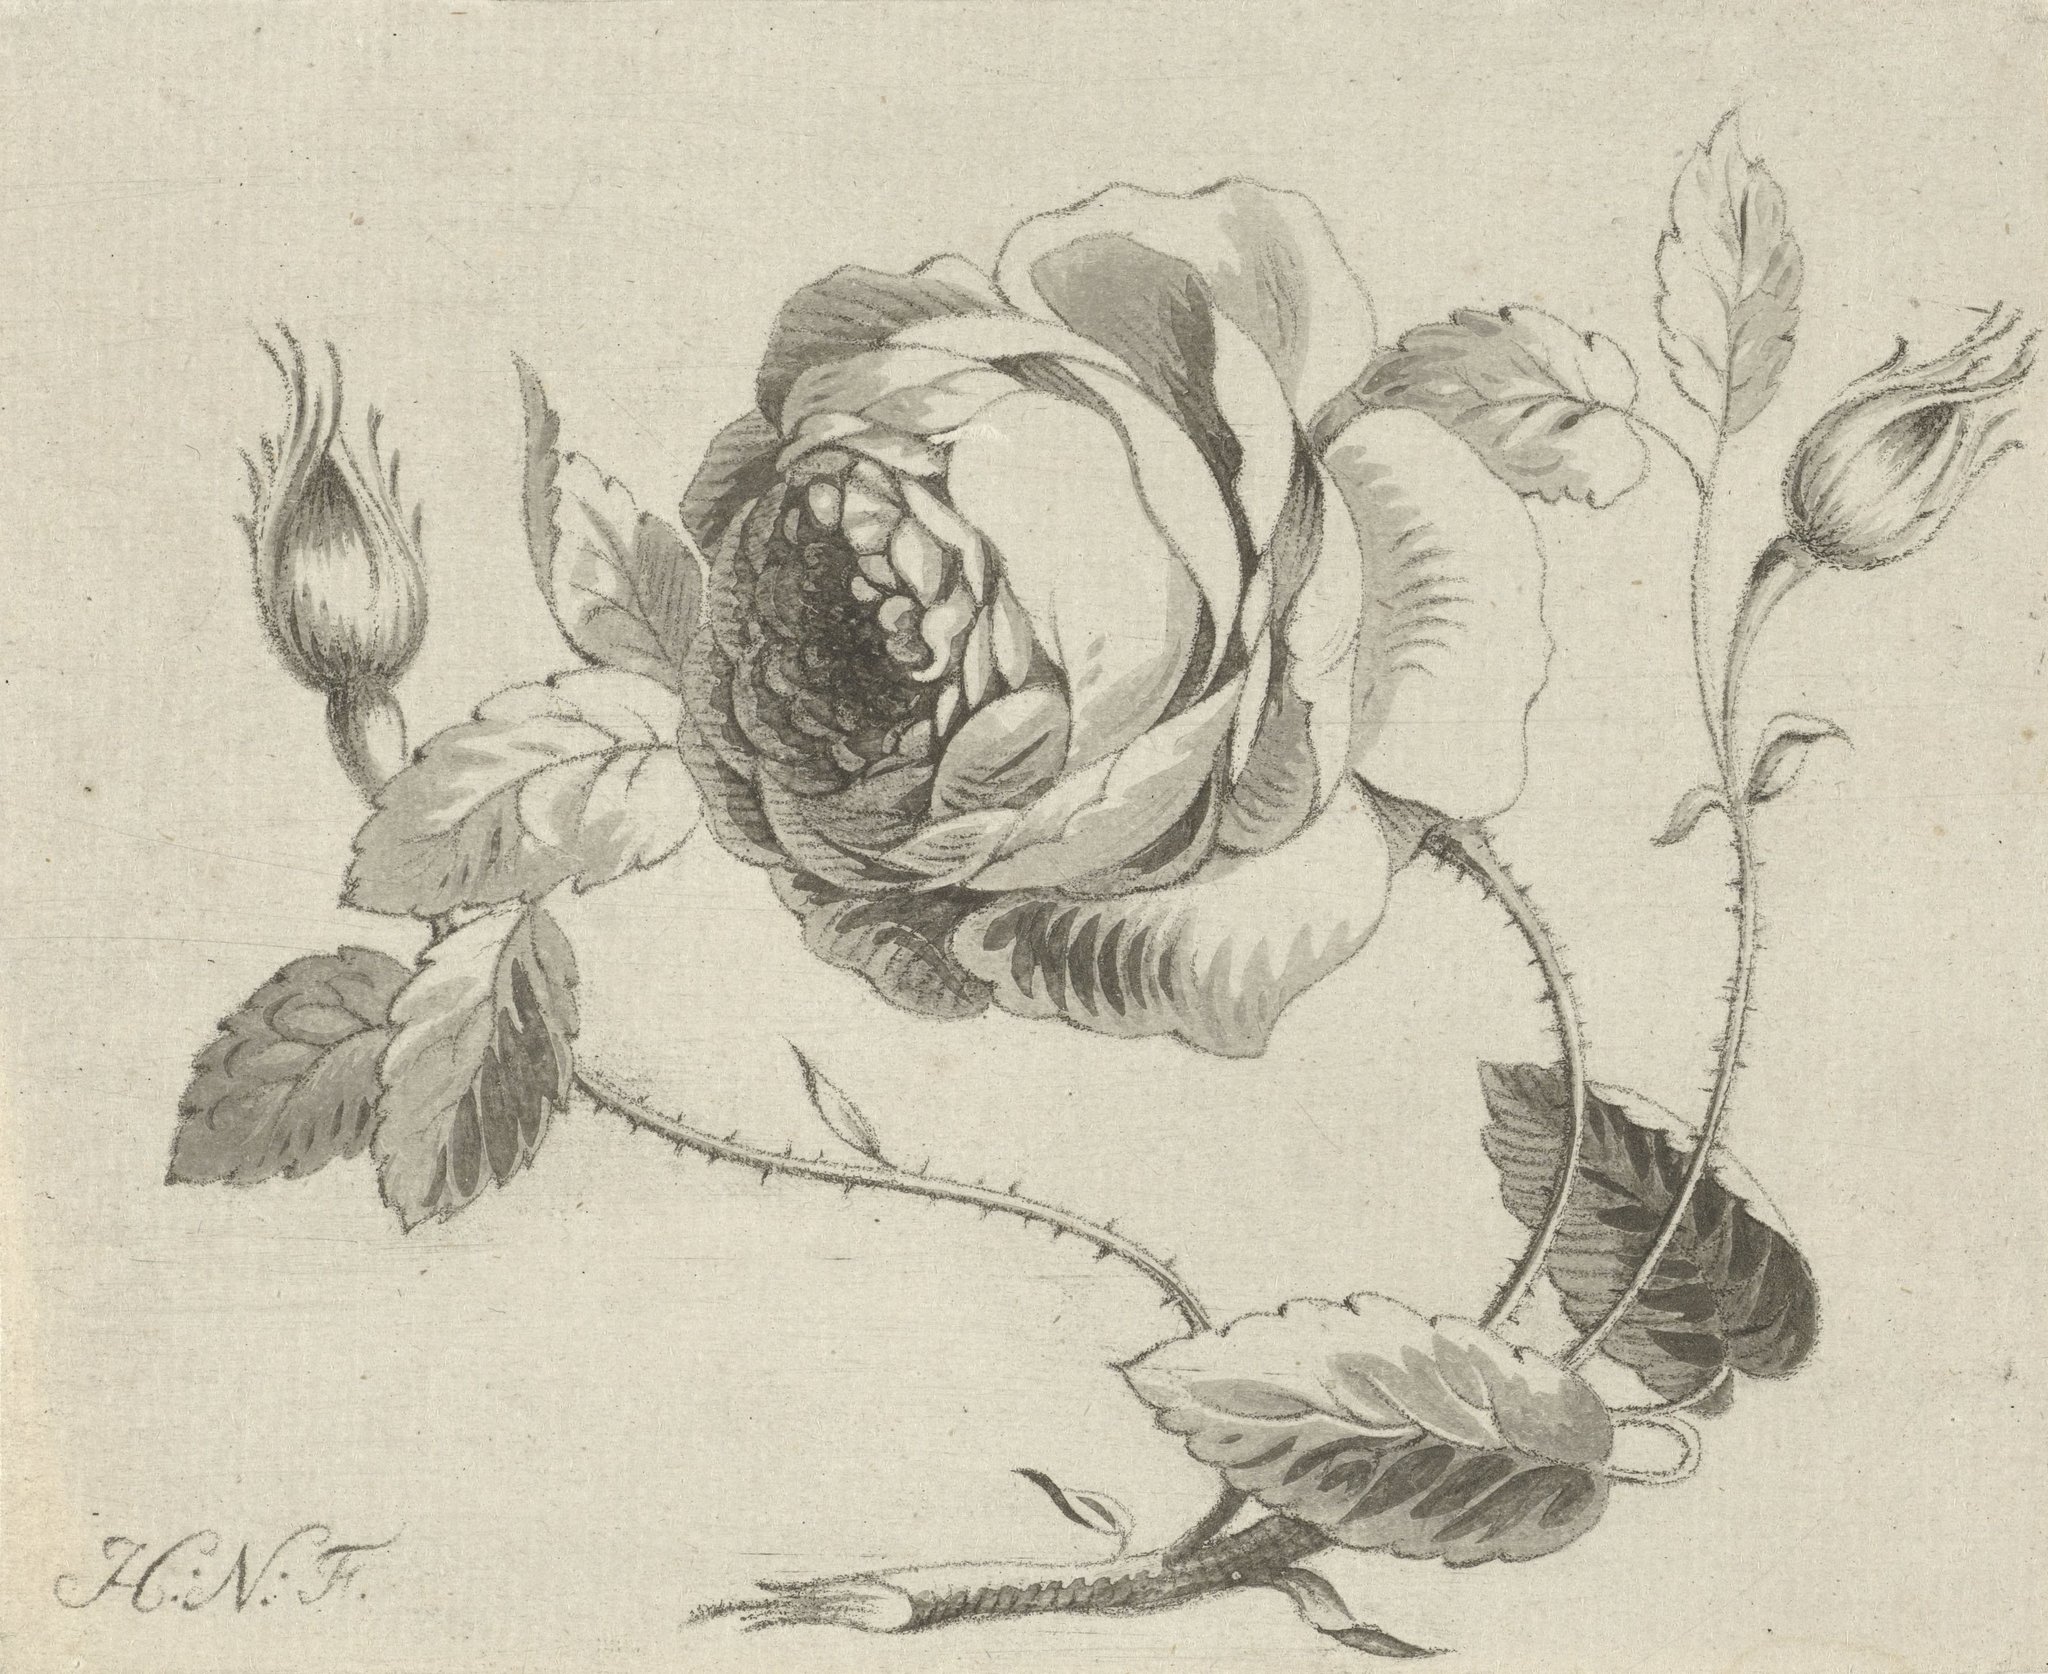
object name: print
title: Roos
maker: hermanus numan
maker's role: draughtsman, painter, print maker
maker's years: 1744-1820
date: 1754-1825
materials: paper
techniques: aquatint, etching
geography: netherlands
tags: flowers: rose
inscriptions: collector's mark: Lugt 2228